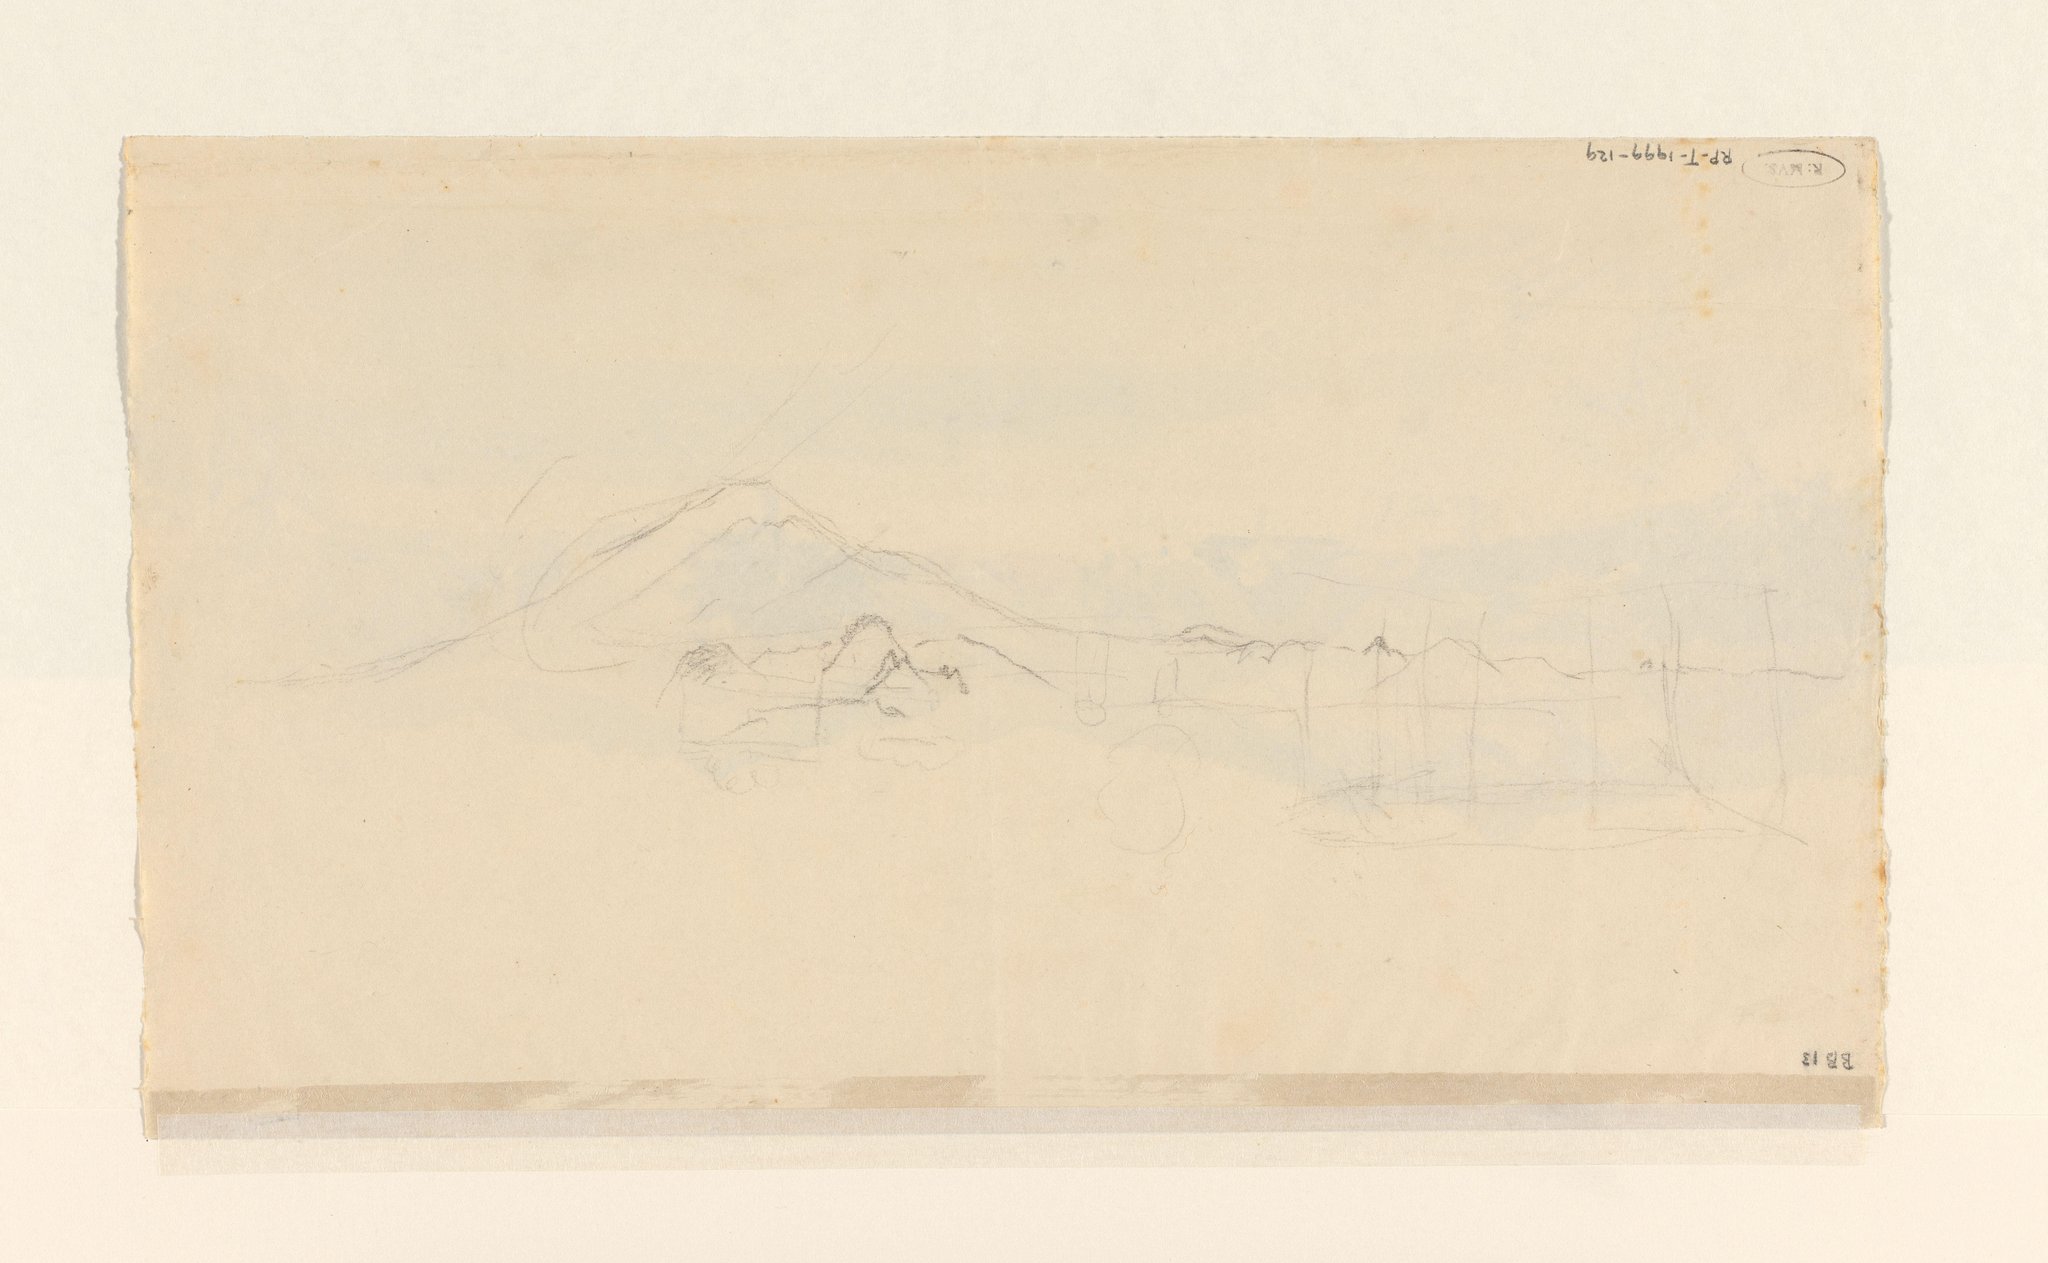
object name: drawing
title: Schets van een berglandschap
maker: adrianus johannes bik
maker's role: draughtsman, print maker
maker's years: 1790-1872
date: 1816-1846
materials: chalk, paper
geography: java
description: artikel over deze collectie in Bulletin van het Rijksmuseum 49 [2001], nr. 4, pp 342 e.v., p. 352, afb. 10